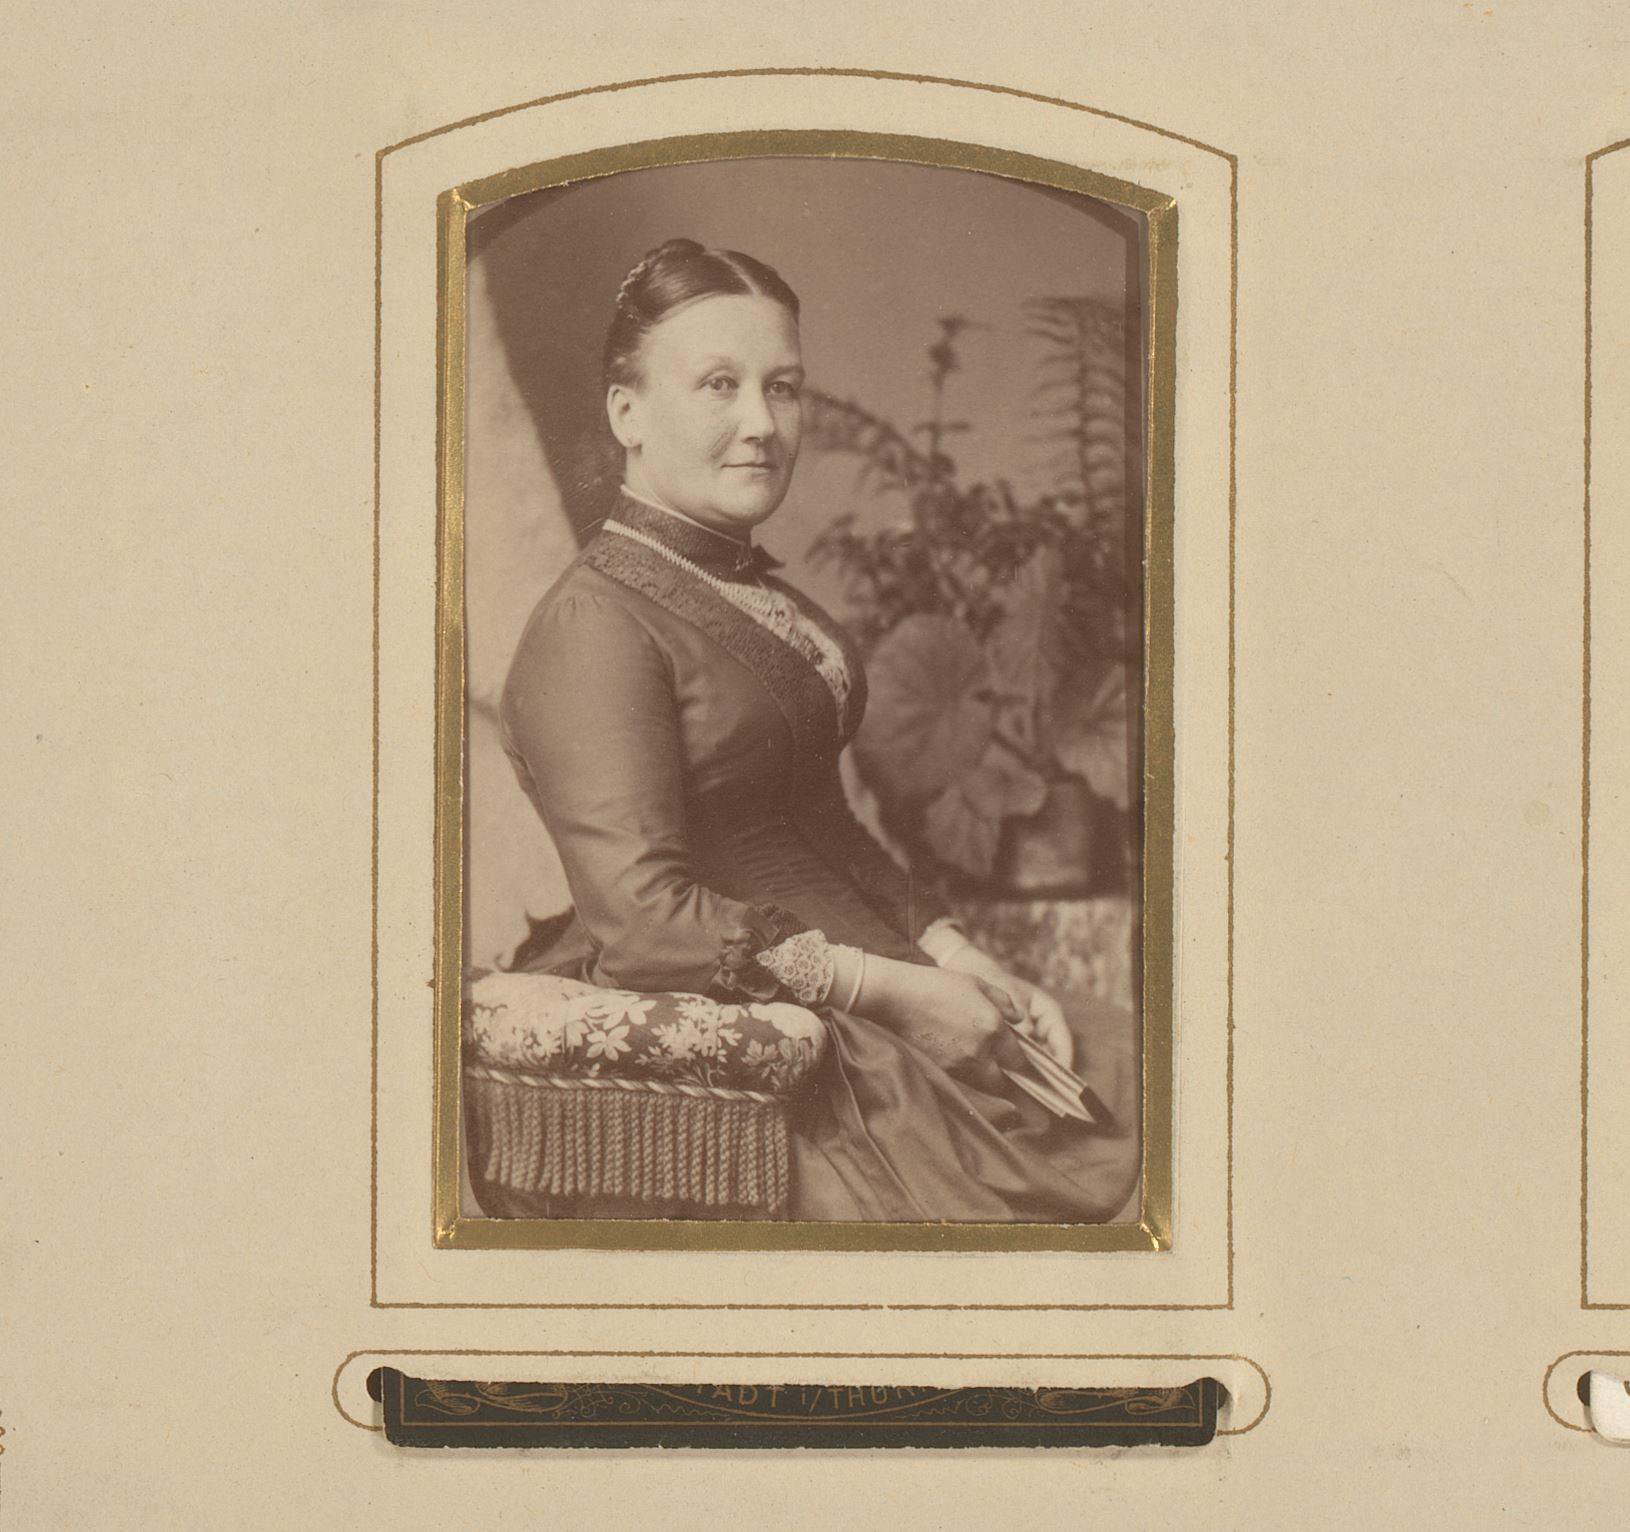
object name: photograph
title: Portret van een zittende vrouw met boek in de hand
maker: r. finzel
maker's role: fotograaf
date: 1850-1900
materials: cardboard, photographic support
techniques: albumen print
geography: arnstadt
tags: sitting figure - aa - female human figure, historical persons - bb - woman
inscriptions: inscription: ‘Photogr. Anstalt von R. Finzel,/ ARNSTADT i/THÜRINGEN.’